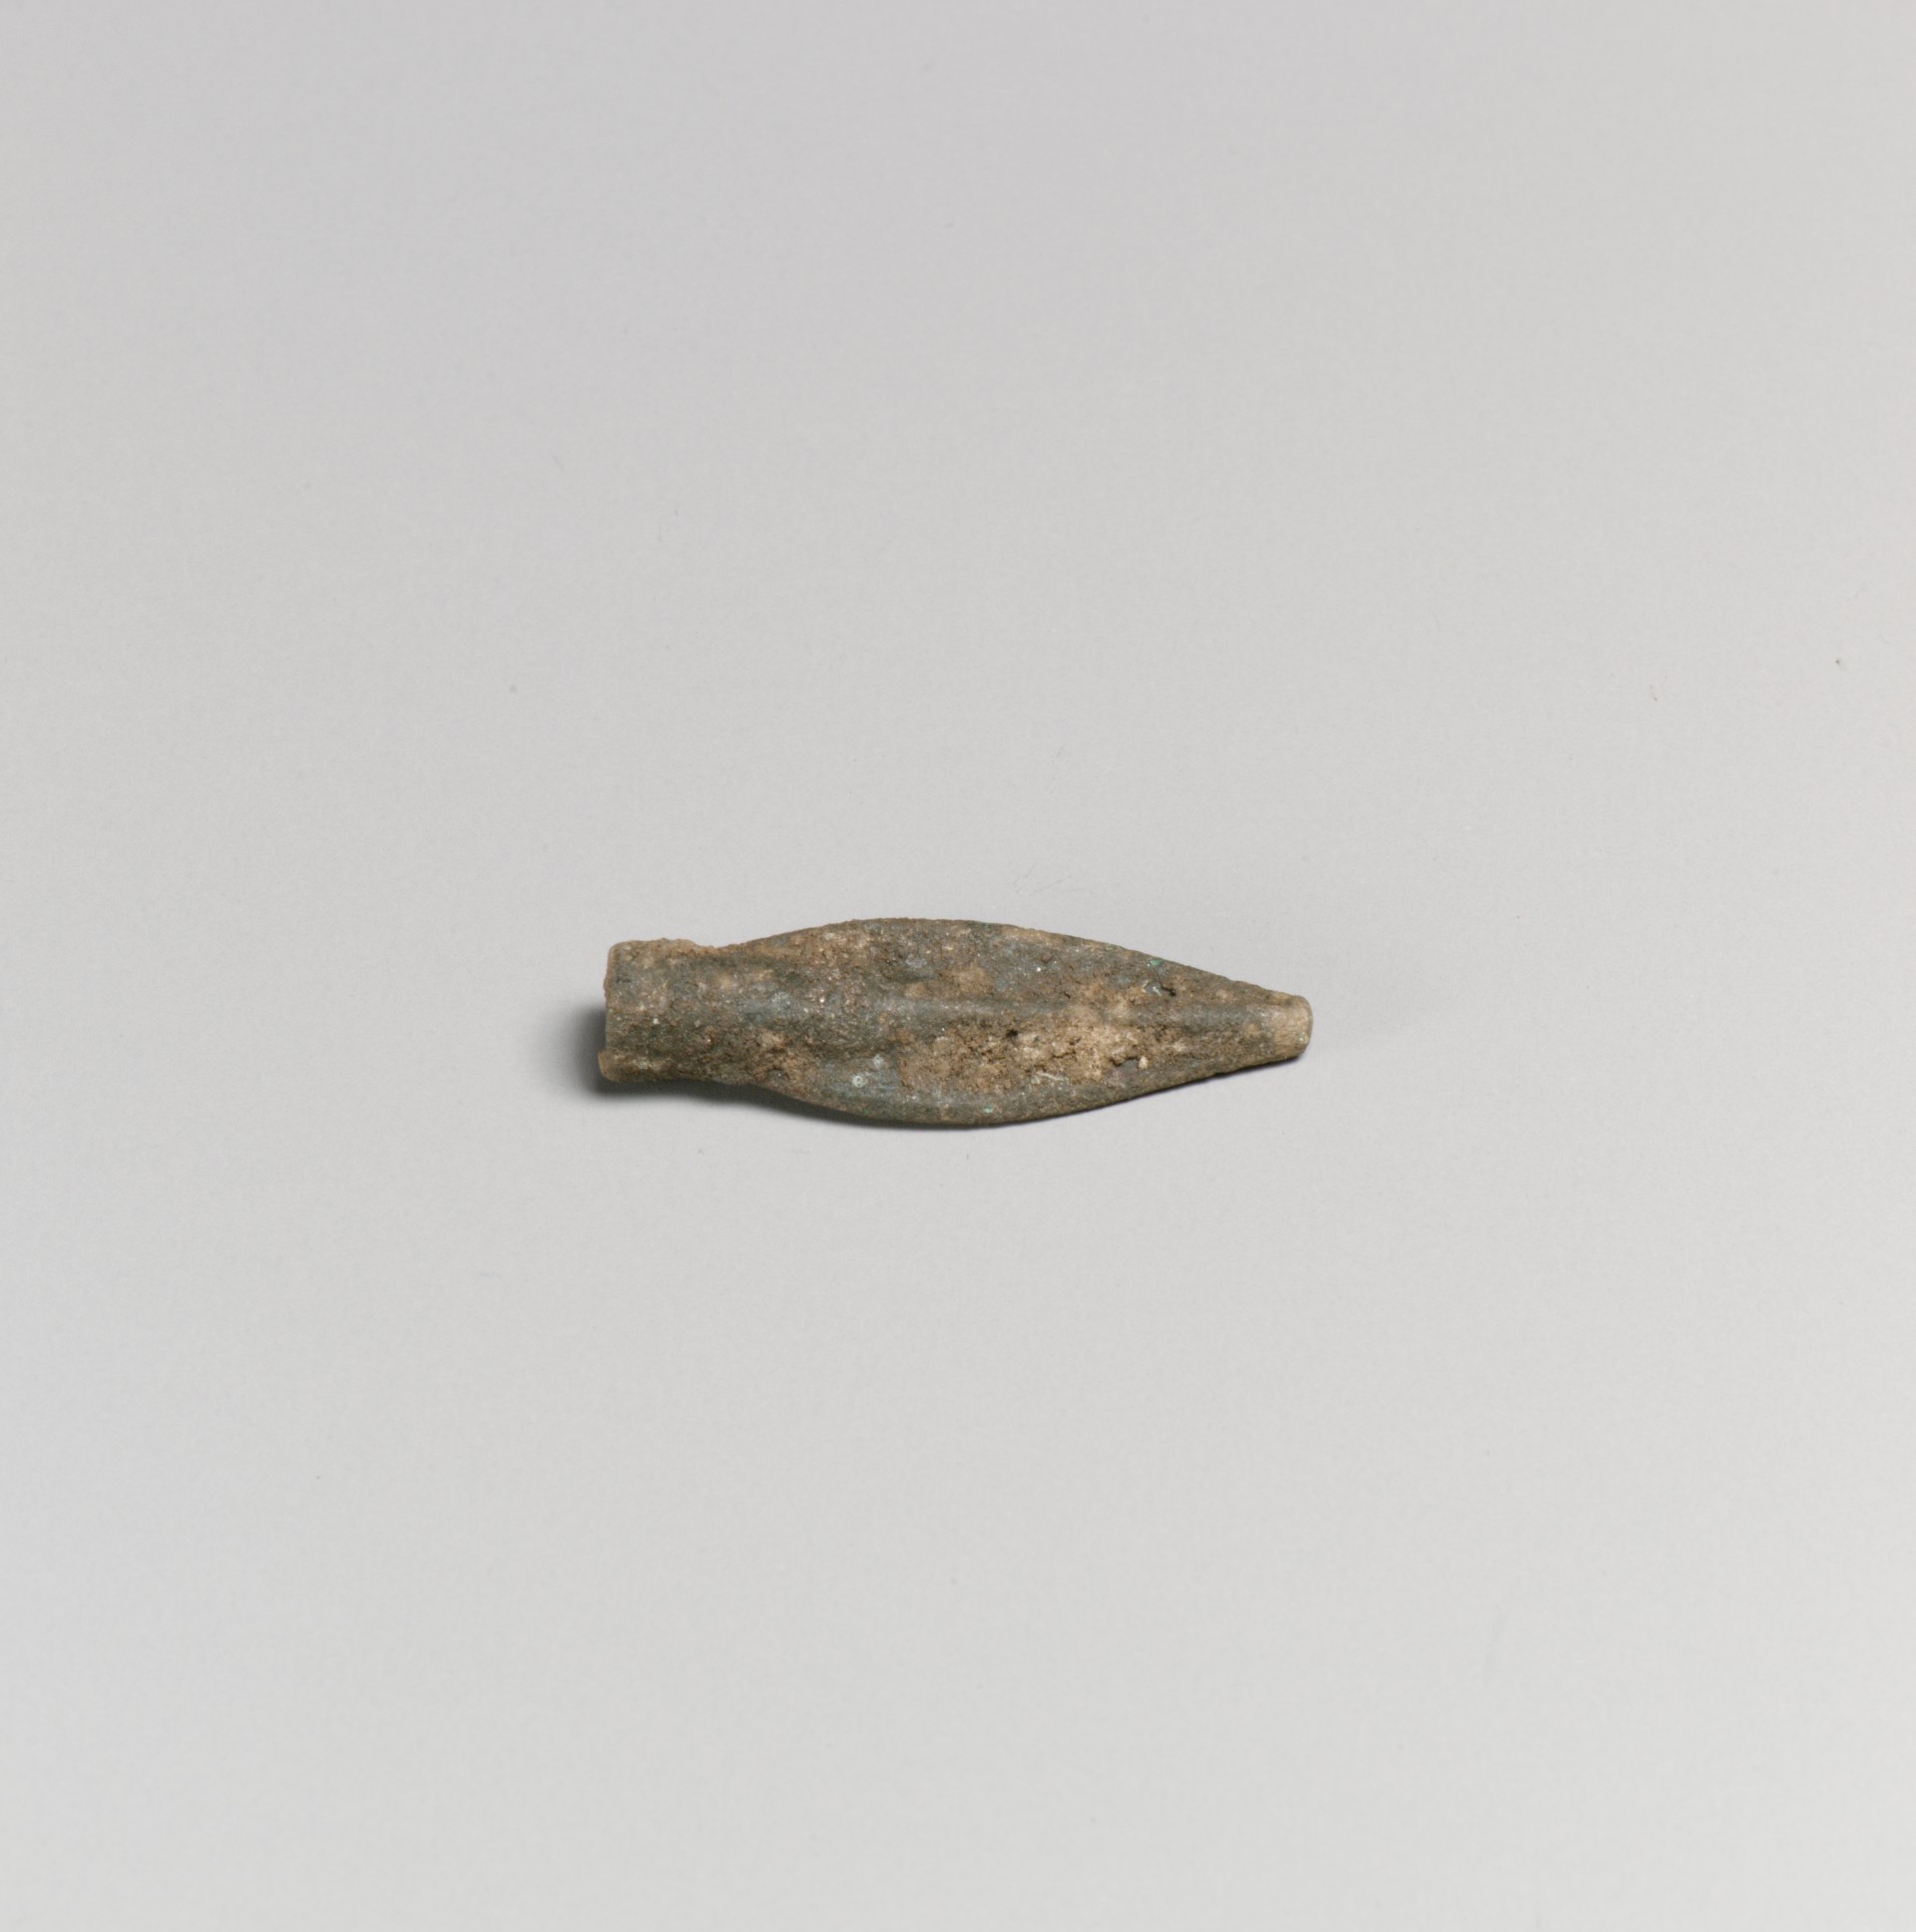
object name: arrowhead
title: Bronze arrowhead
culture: achaemenid or greek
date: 400-501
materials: bronze